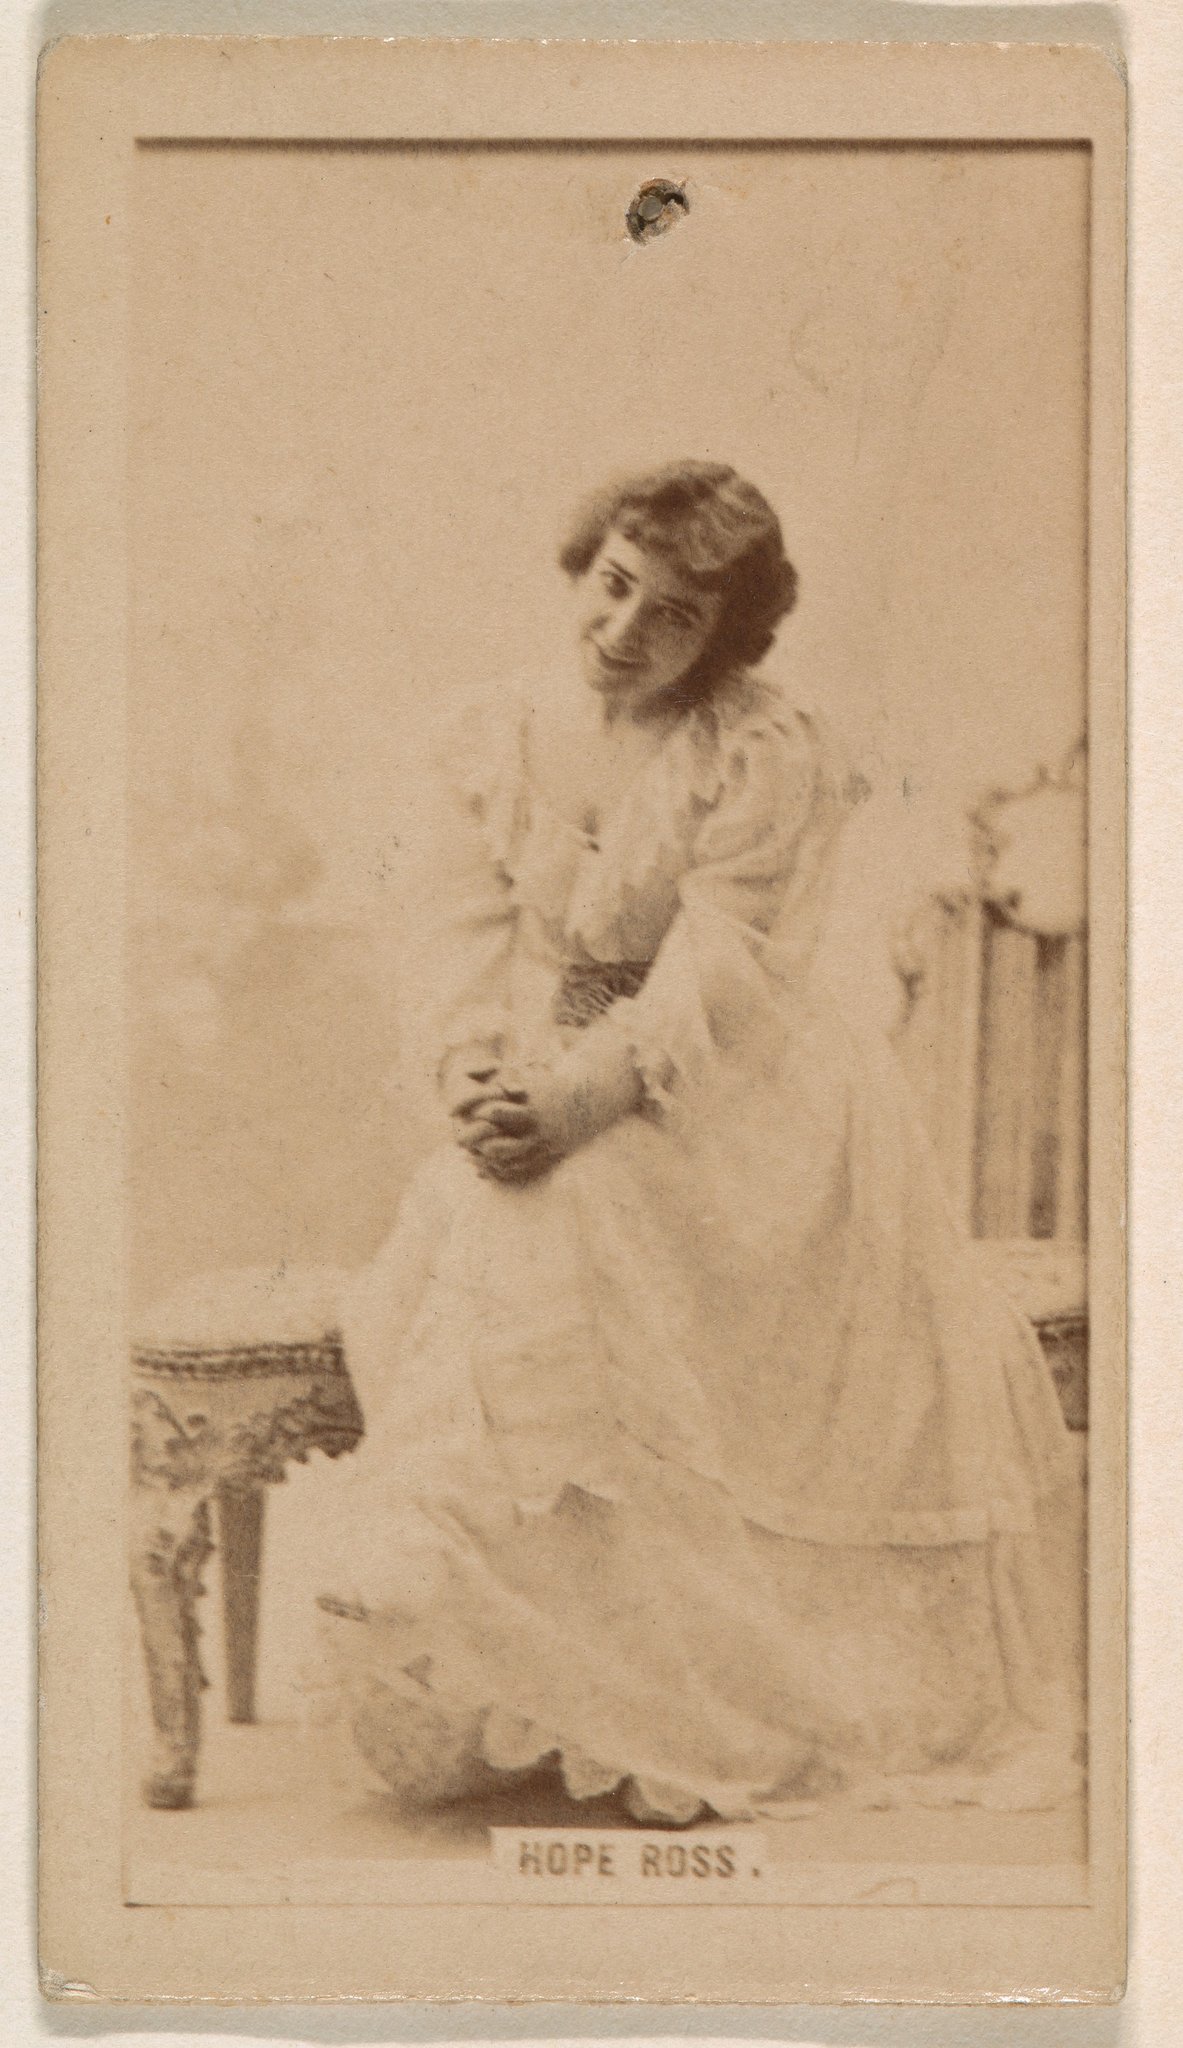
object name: photograph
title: Hope Ross, from the Actresses series (N245) issued by Kinney Brothers to promote Sweet Caporal Cigarettes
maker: kinney brothers tobacco company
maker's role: publisher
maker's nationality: american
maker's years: 1869-2011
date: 1890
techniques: albumen silver print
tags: portraits,women,actresses